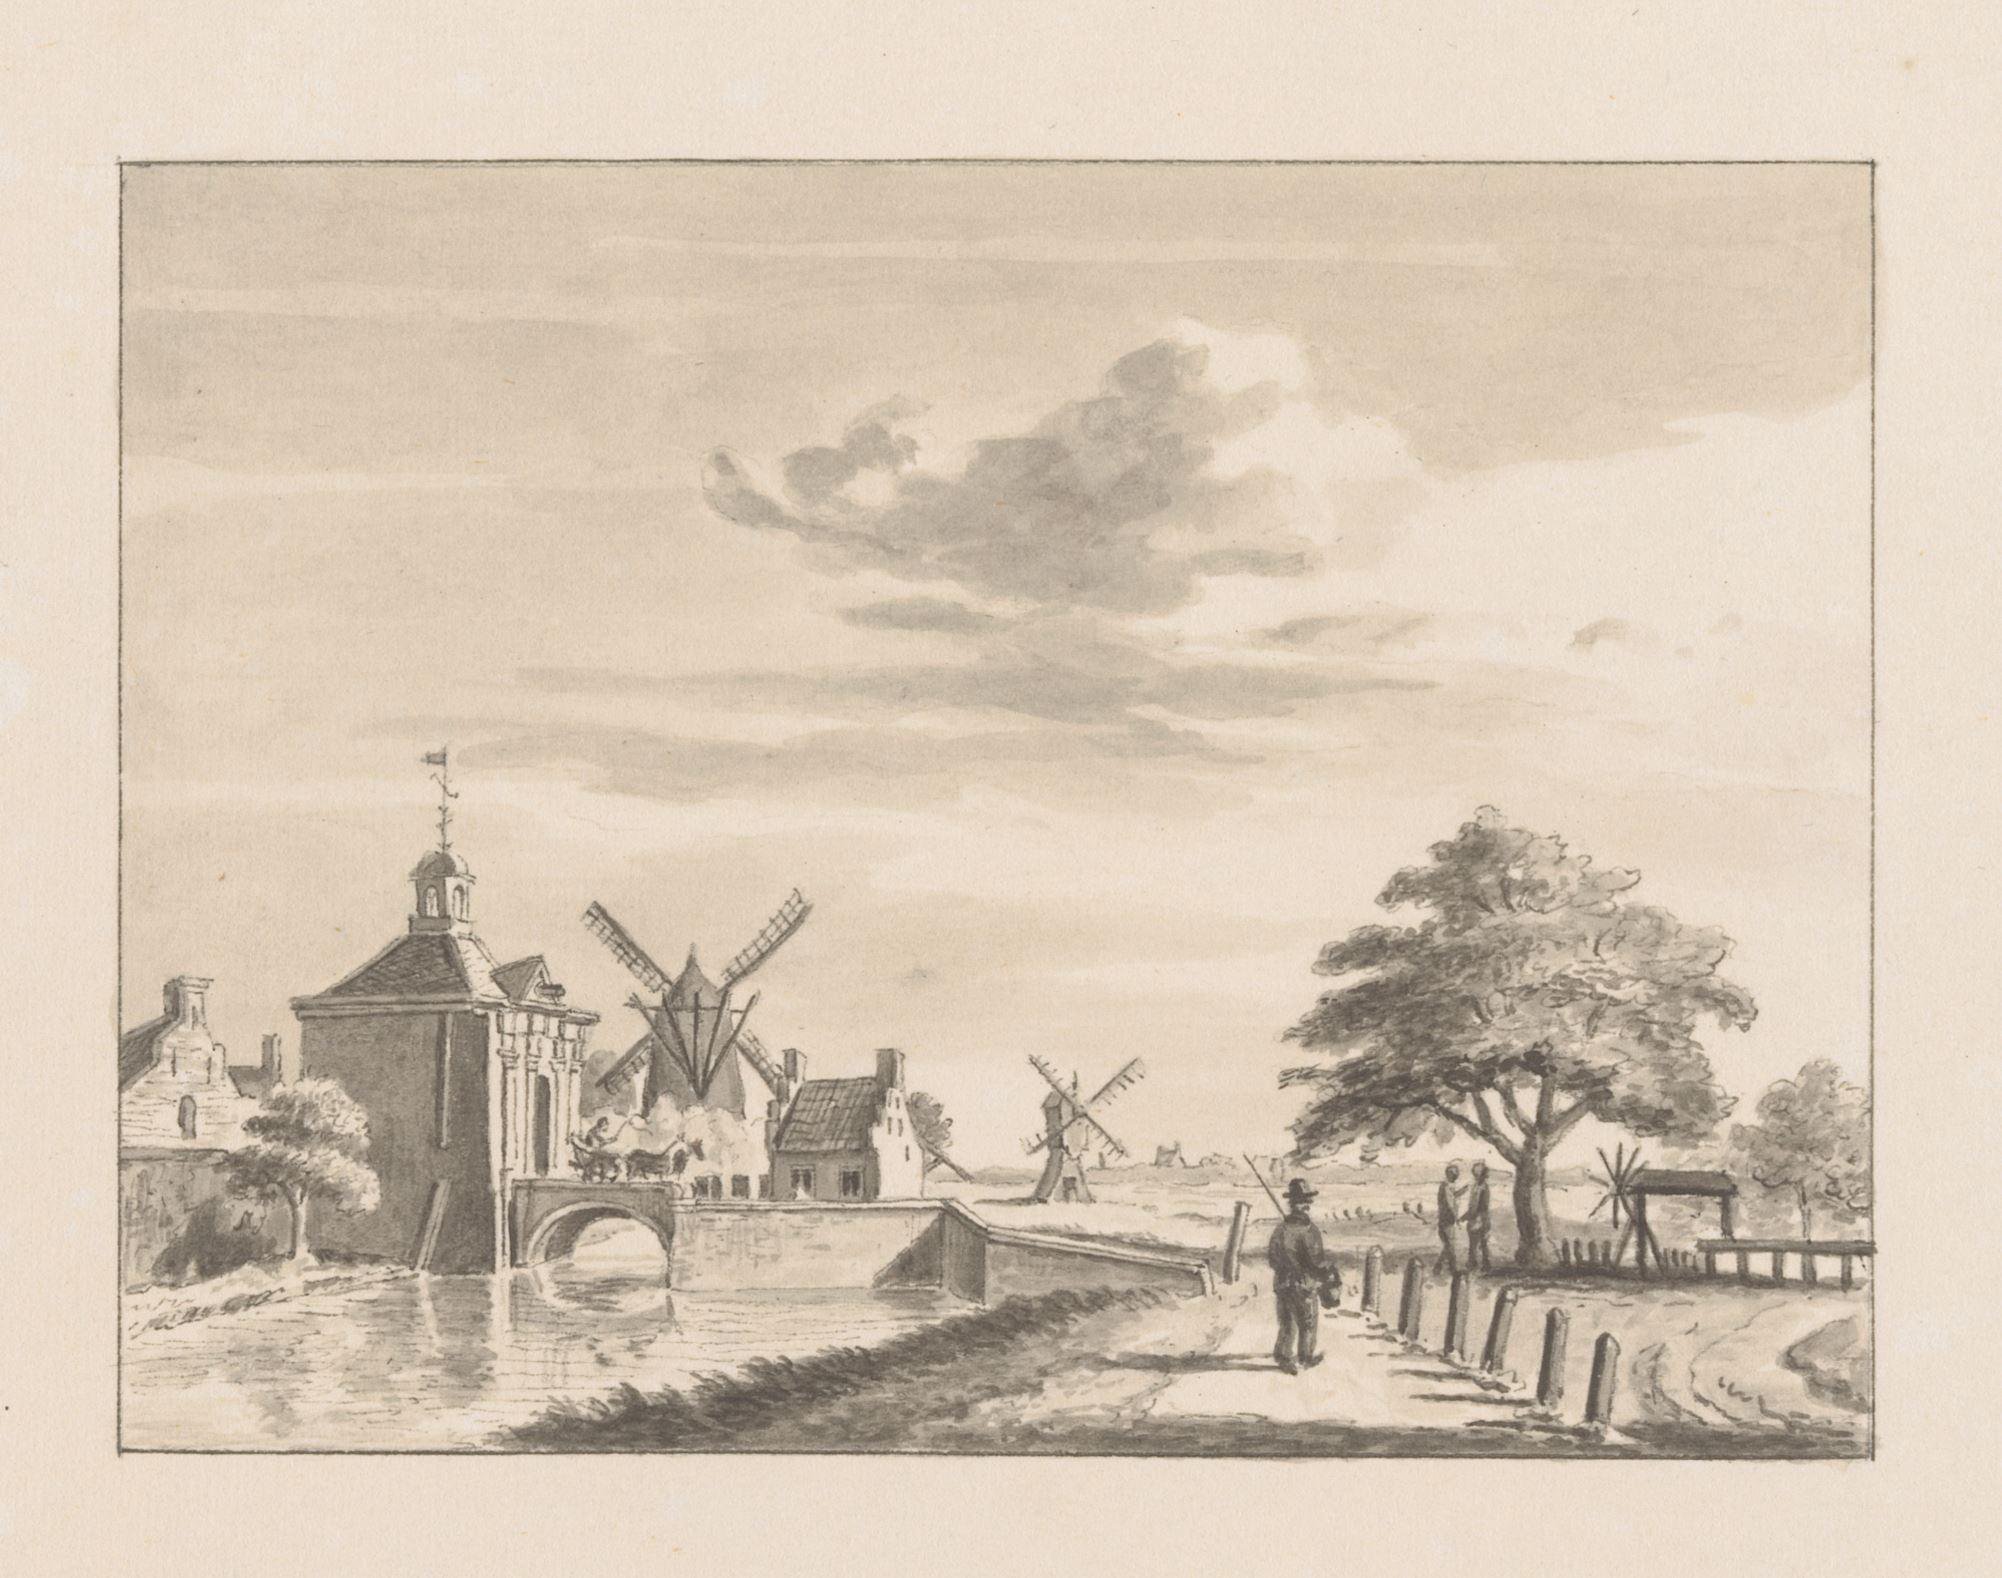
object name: drawing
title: Gezicht op de Benschopperpoort in IJsselstein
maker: Anonymous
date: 1750-1850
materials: ink, paper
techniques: brush, drawing, pen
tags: city-gate